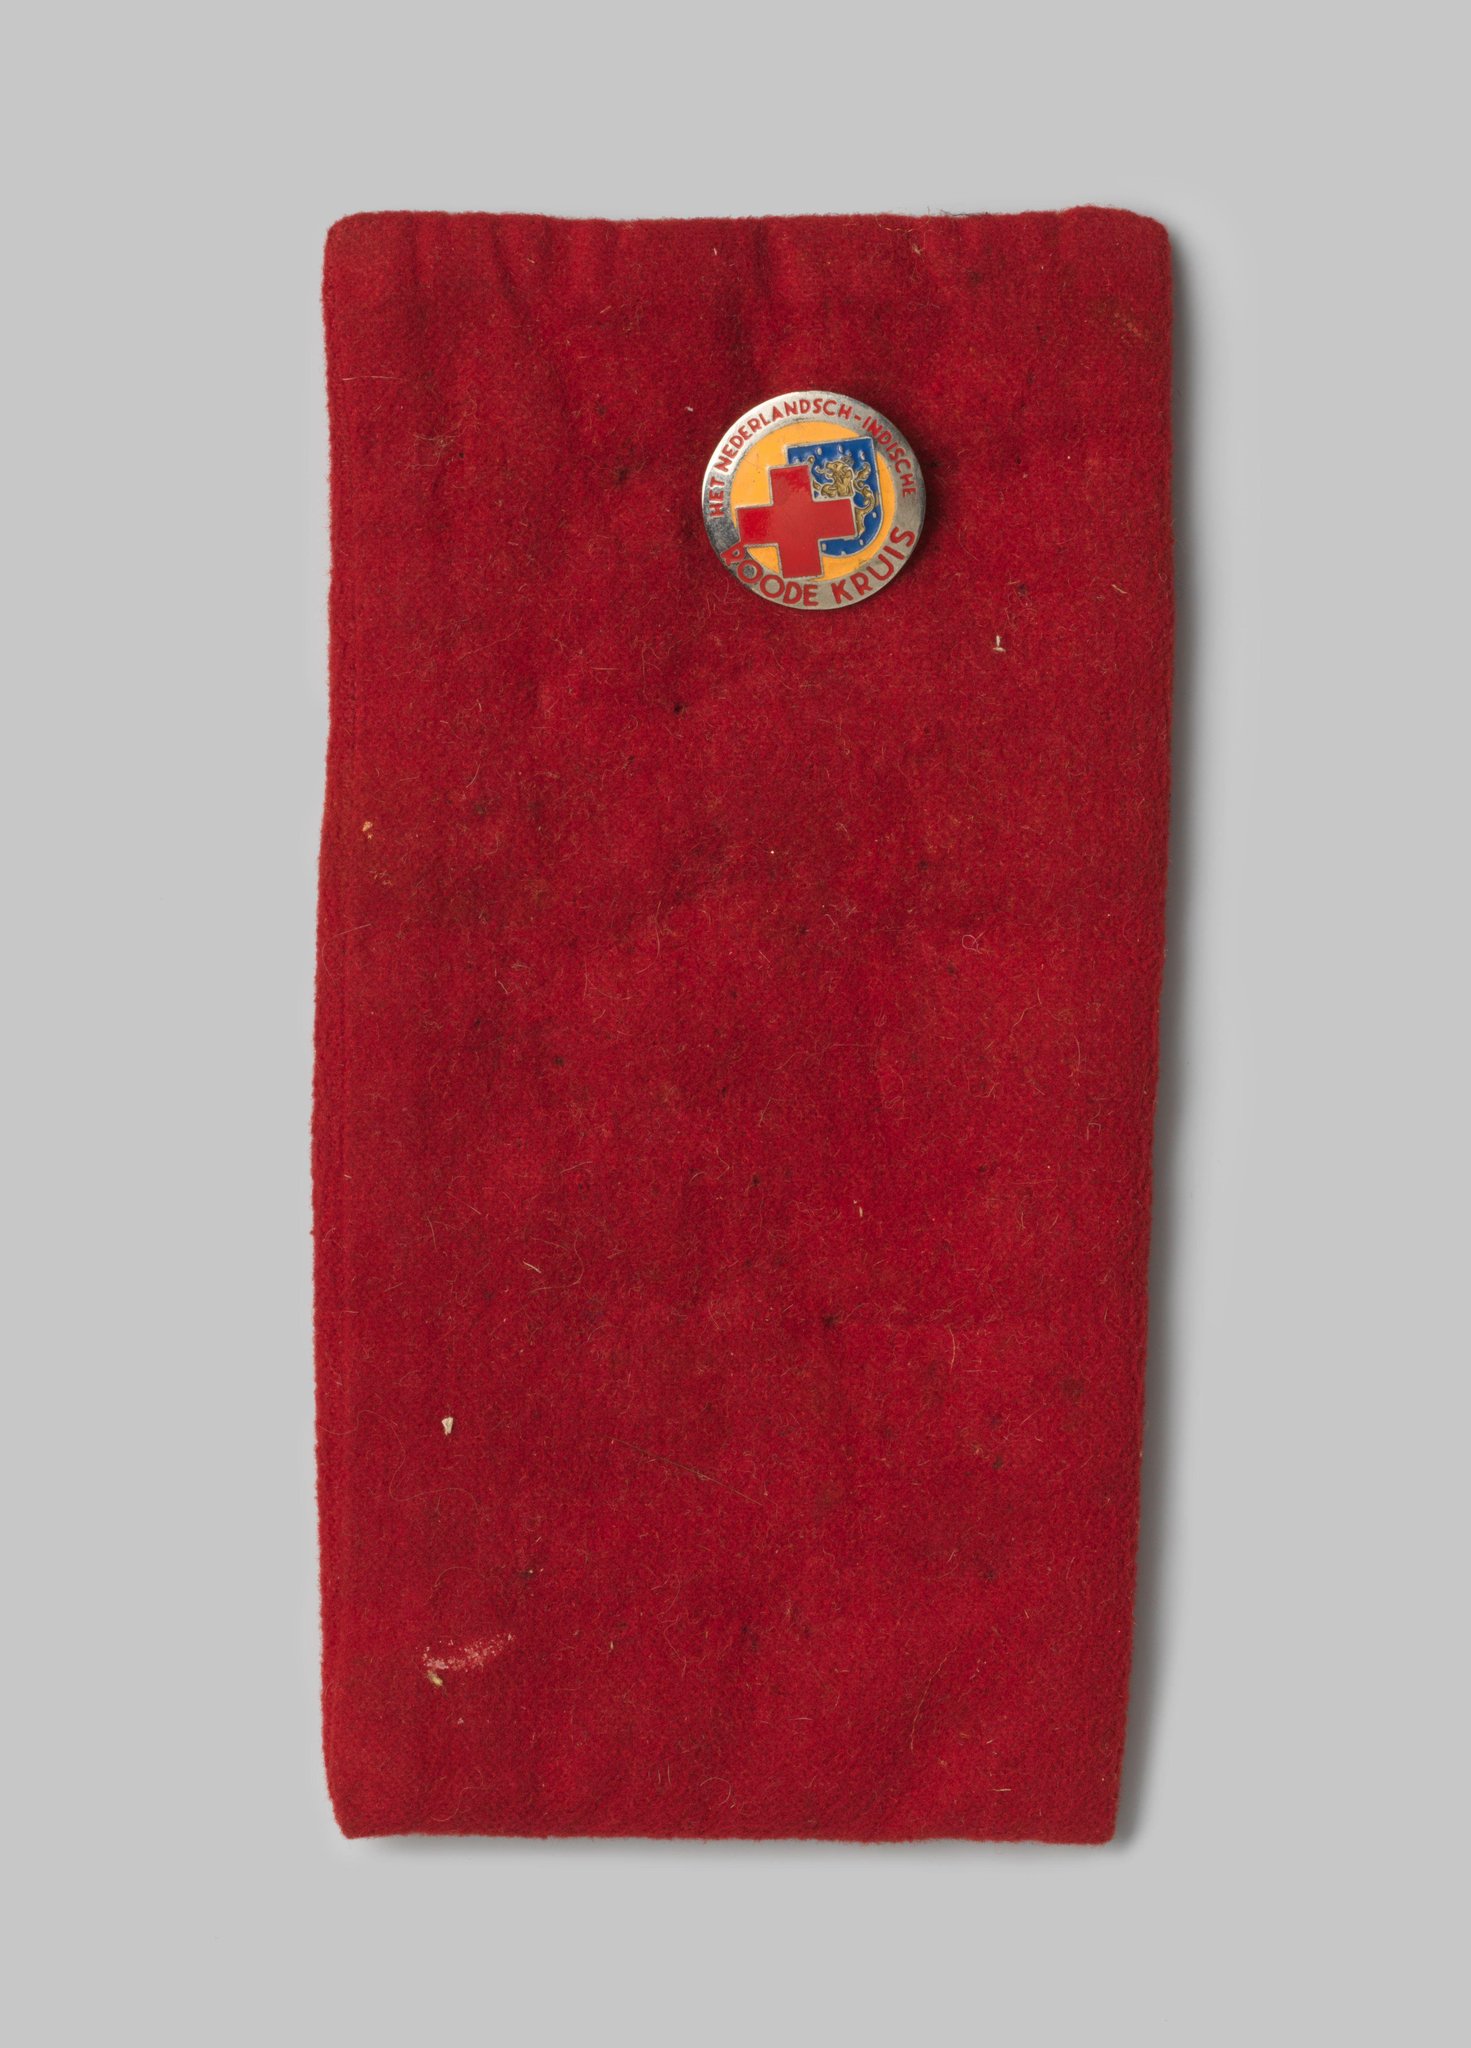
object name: brooch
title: Speld van het Nederlandsch-Indisch Roode Kruis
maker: johan wouter beijleveld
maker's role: regisseur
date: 1938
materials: enamel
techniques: enamel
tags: rode kruis, het nederlandse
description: Speld van het Nederlandsch-Indisch Roode Kruis. De speld is rond van vorm. De letters staan op de buitenste rand. In het centrale deel is op een donkergeel fond een rood kruis afgebeeld met het wapen van het Koninkrijk der Nederlanden in blauw- en goudkleur daarachter.